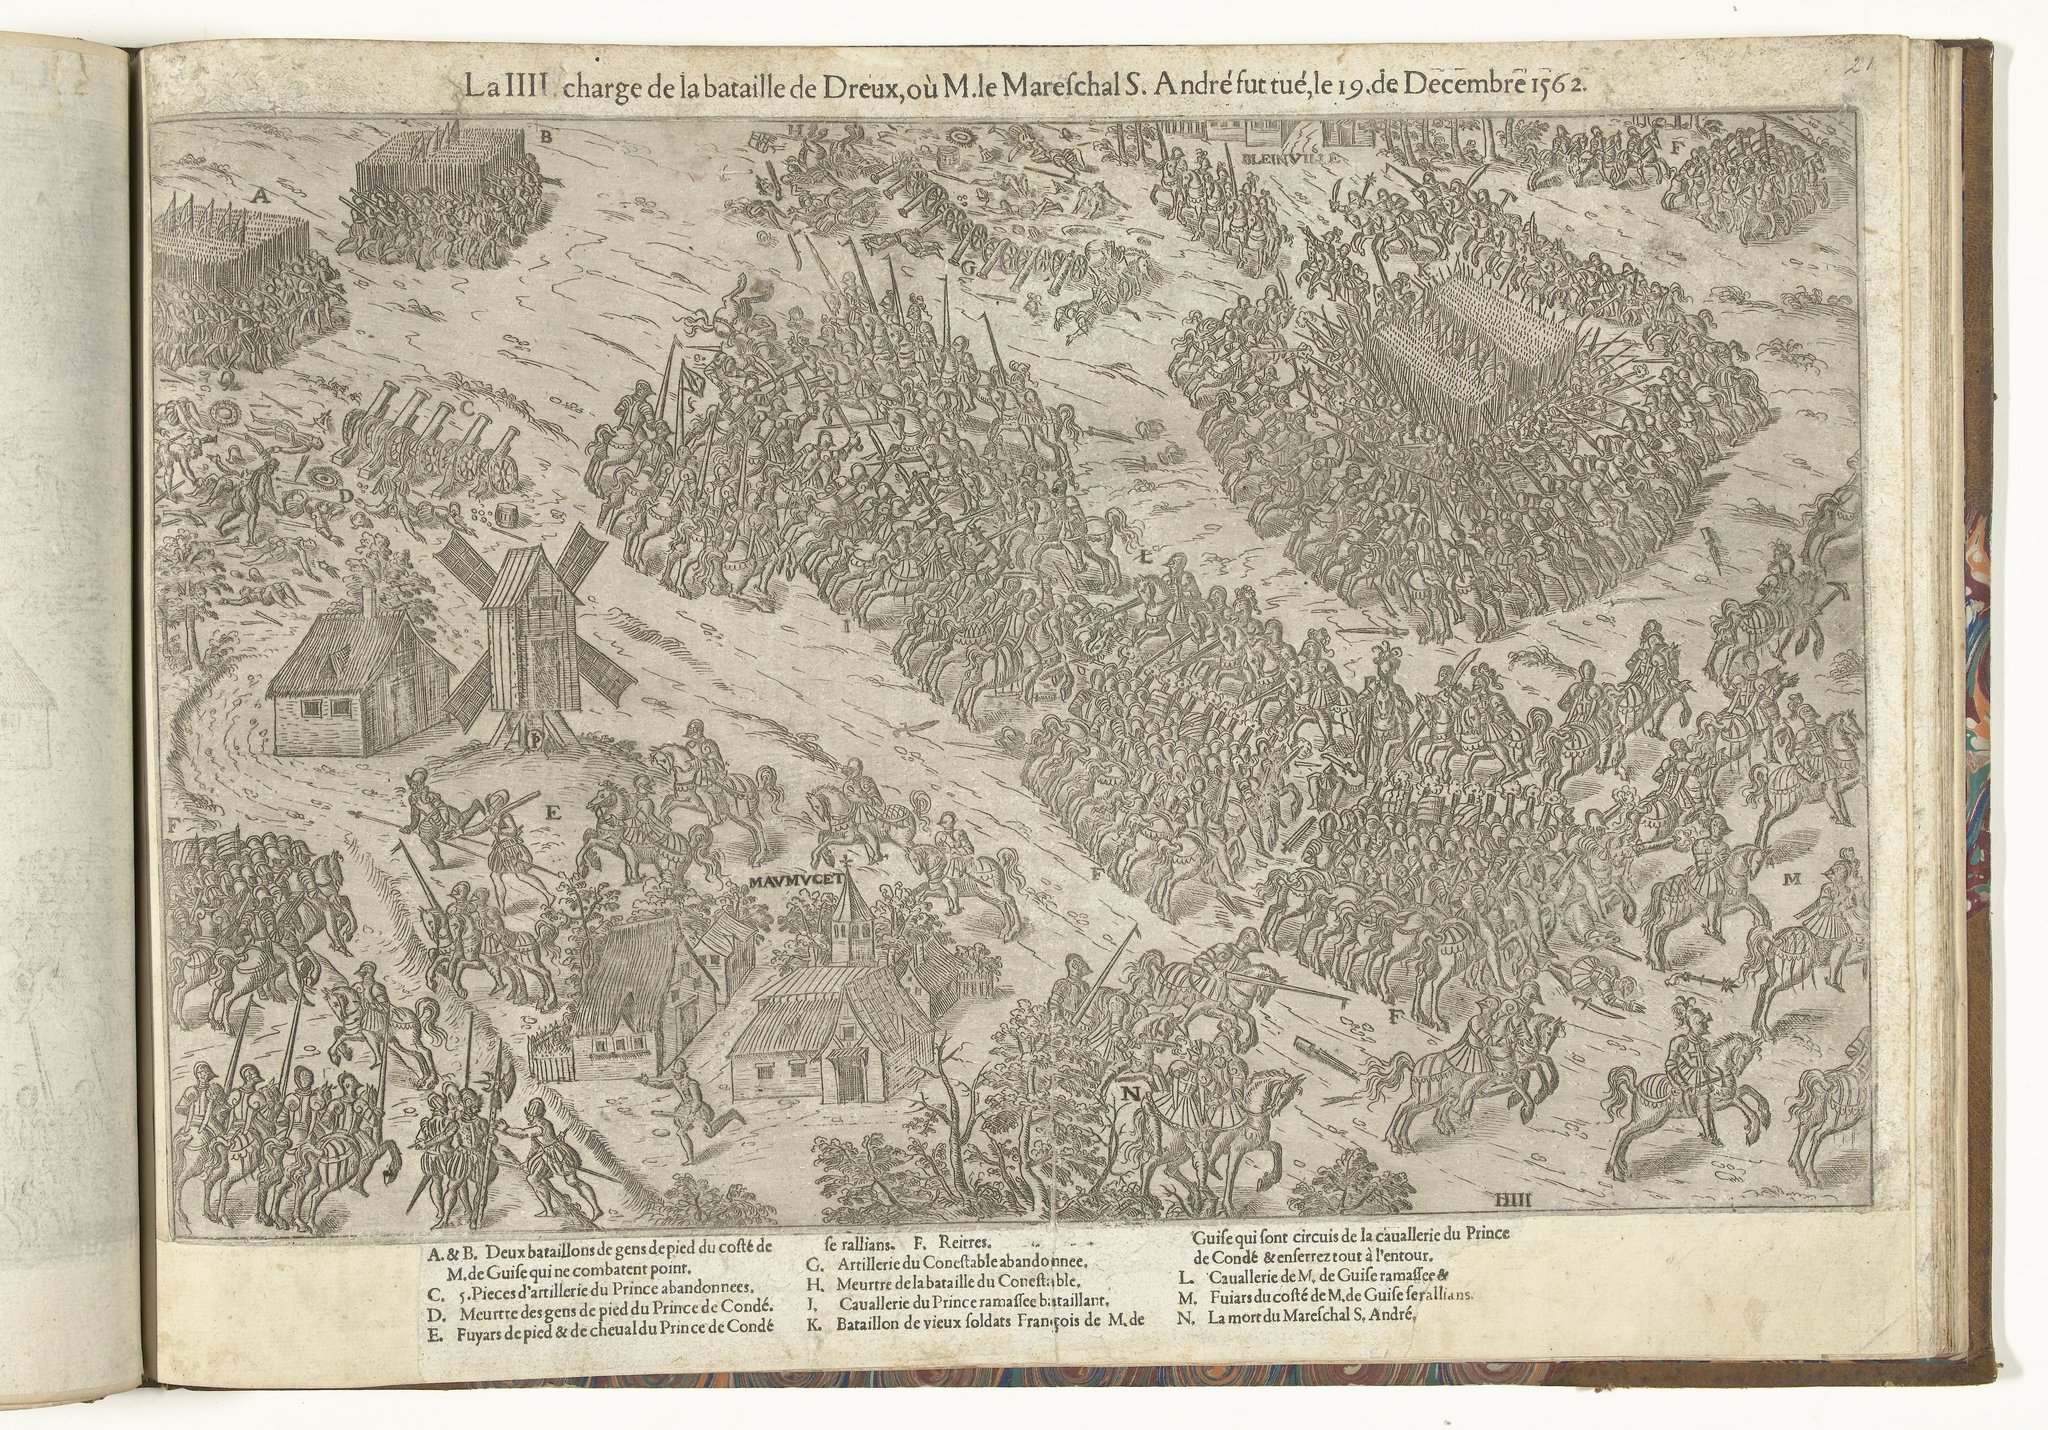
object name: history print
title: Slag bij Dreux, vierde treffen, 1562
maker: jean perrissin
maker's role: print maker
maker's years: 1536-1611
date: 1570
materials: paper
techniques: etching, letterpress printing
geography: france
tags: battle, fighting in general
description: Slag bij Dreux tussen de hugenoten en de katholieken, vierde treffen, 19 december 1562. Gezicht op het slagveld. In het onderschrift de legenda A-N in het Frans. Ongenummerd.